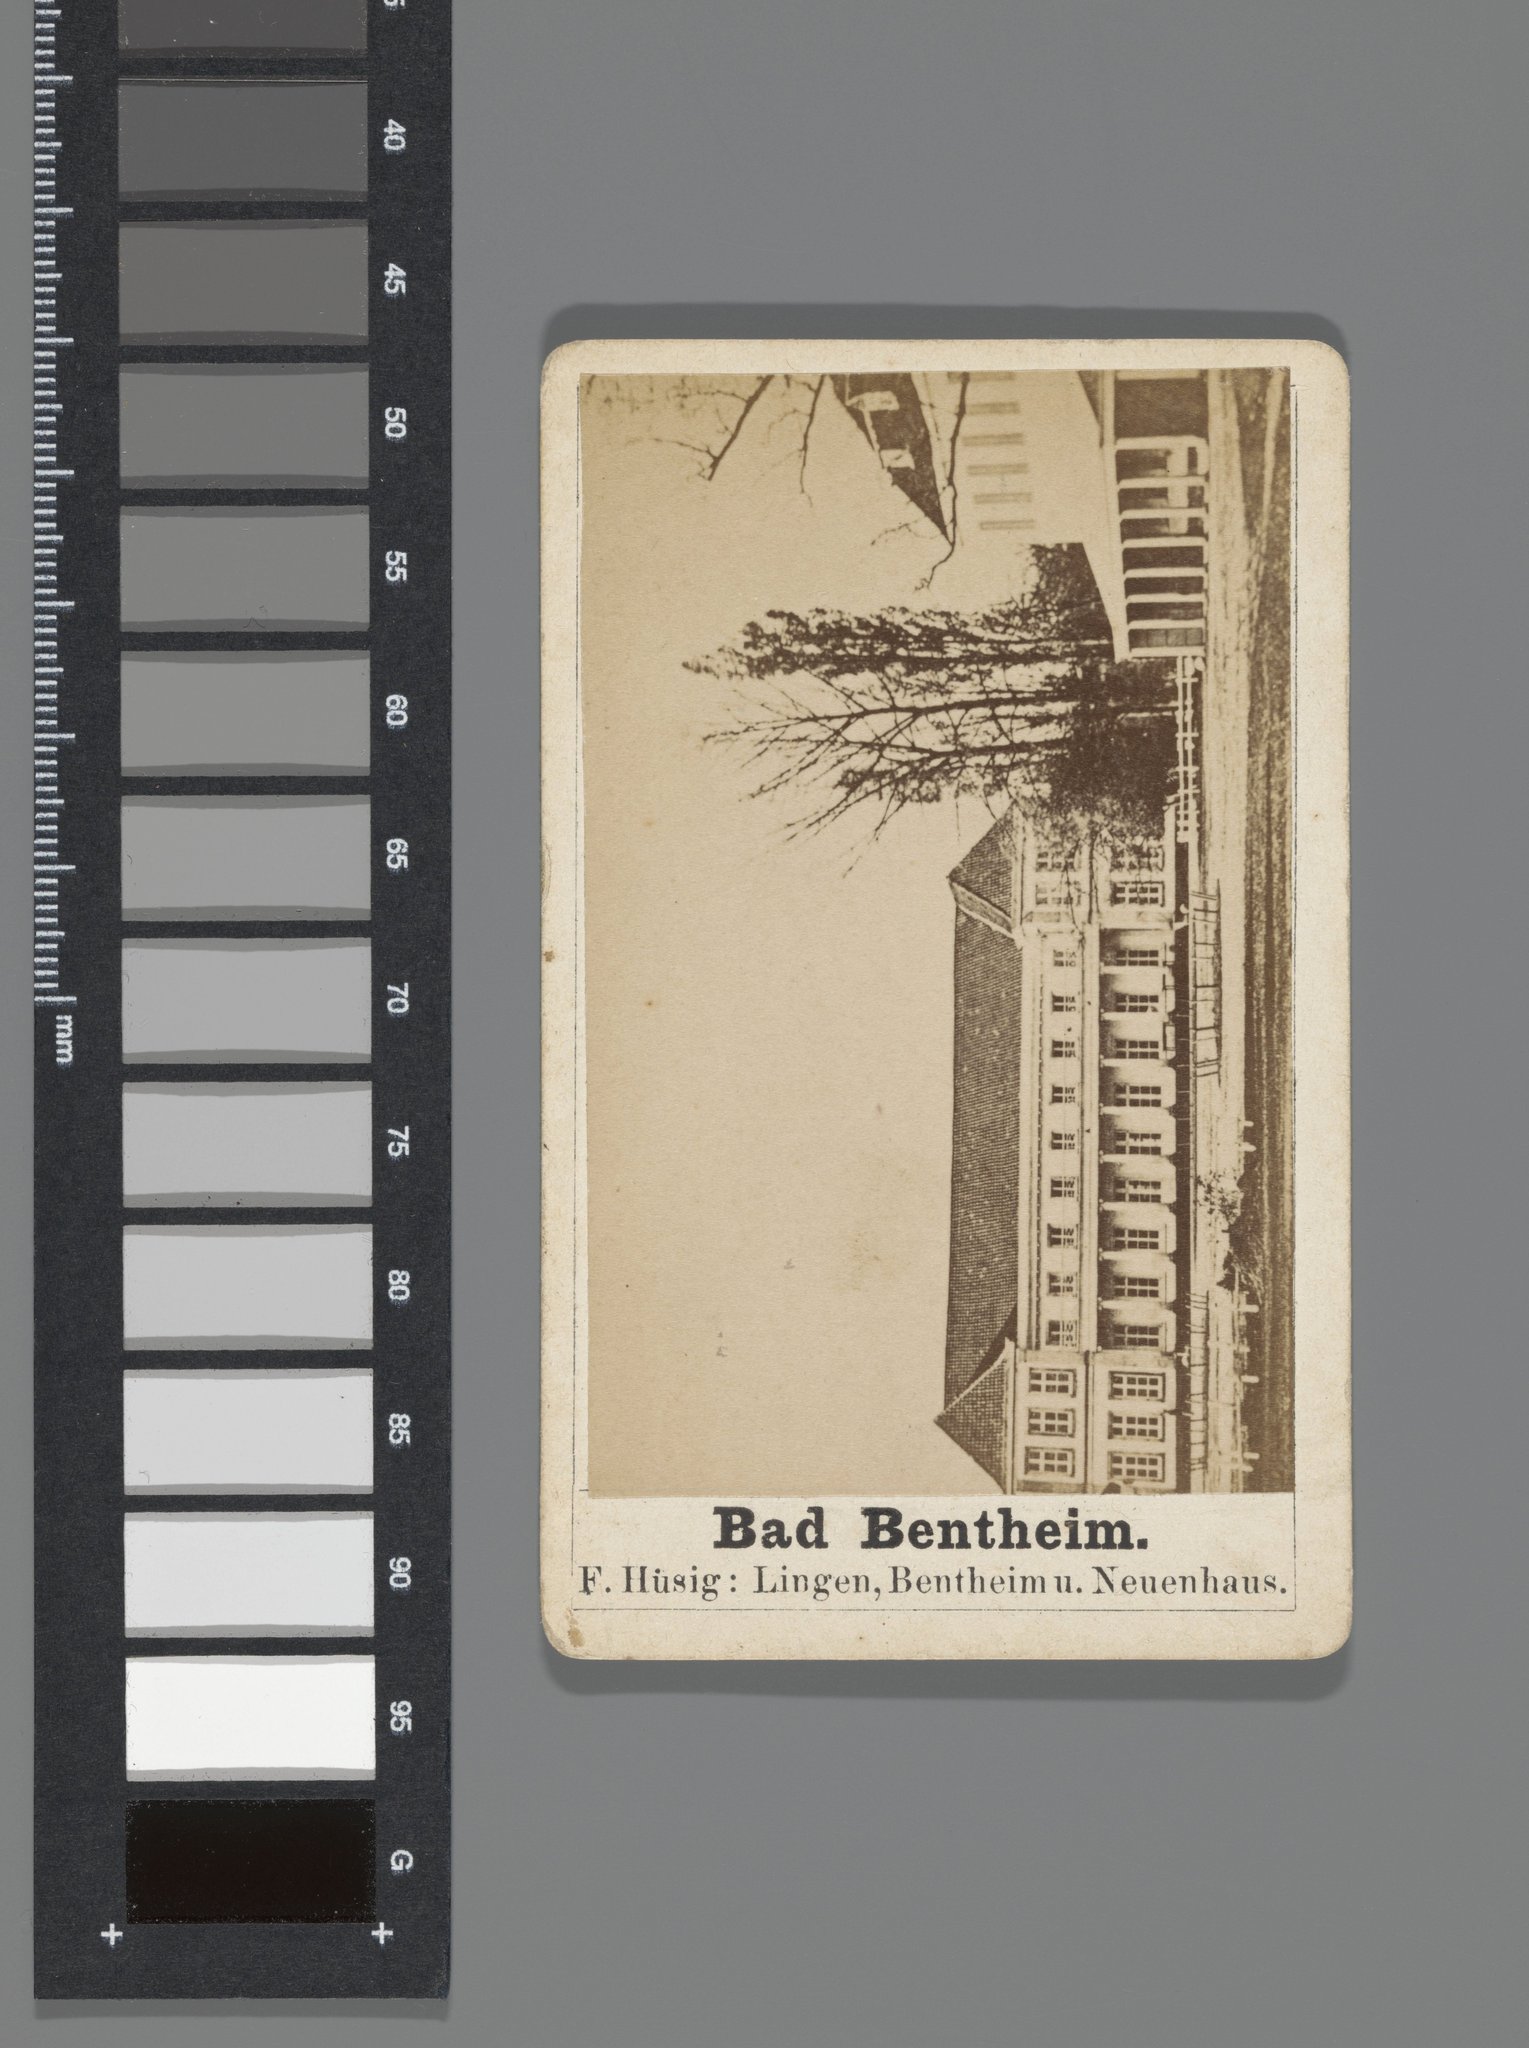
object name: photograph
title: Bad Bentheim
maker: fritz hüsig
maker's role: fotograaf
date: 1870-1885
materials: cardboard, paper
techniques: albumen print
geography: bad bentheim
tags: exterior ~ representation of a building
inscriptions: inscription: ‘Photogr. Atelier/ von/ Friz Hüsig/ LINGEN./ NIEPCE. DAGUERRE. TALBOT./ Die Platte/ bleibt für Nachbestellungen aufbewahrt.’